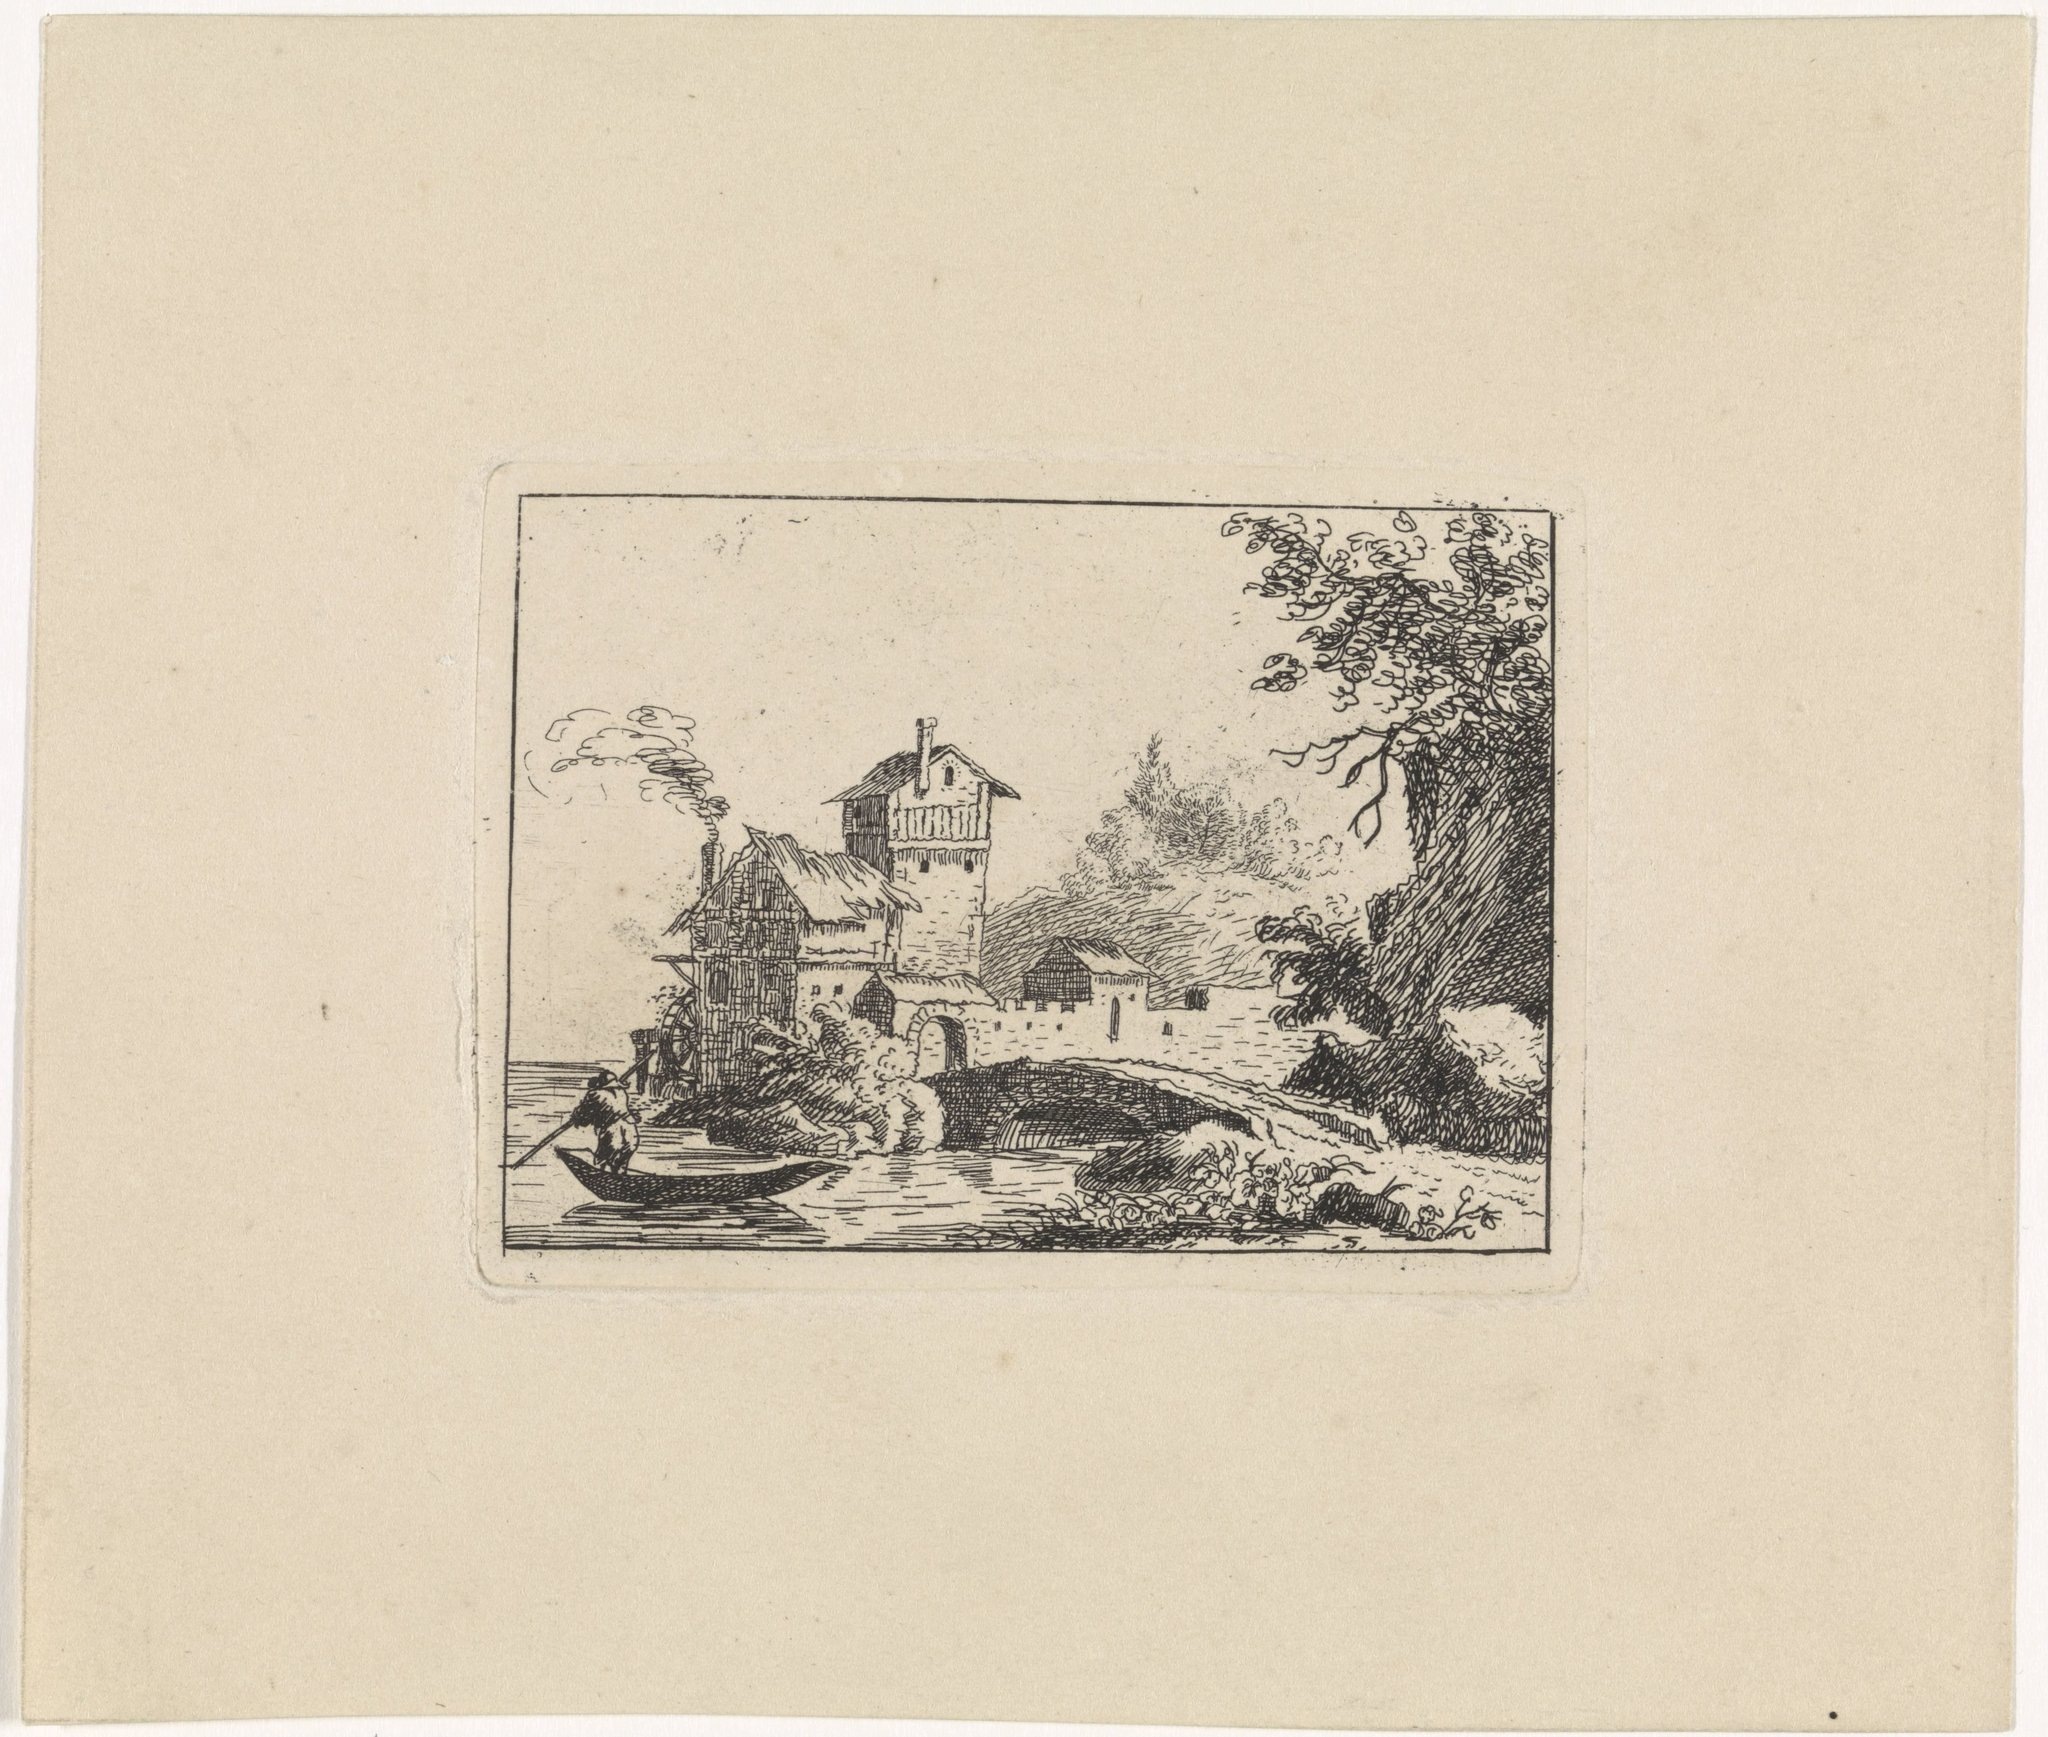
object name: print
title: Landschap met een dorp aan het water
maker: paulus kerkhof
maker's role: print maker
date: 1840-1850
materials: paper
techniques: etching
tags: landscapes with waters, waterscapes, seascapes (in the temperate zone), village, rowing-boat, canoe, etc., watermill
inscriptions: collector's mark: Lugt 2227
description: Landschap met een dorp aan het water en op de voorgrond een man in een boot. Rechts van de man is een brug te zien die naar de dorpsmuur leidt. Achter de muur bevinden zich verschillende gebouwen en een waterrad.